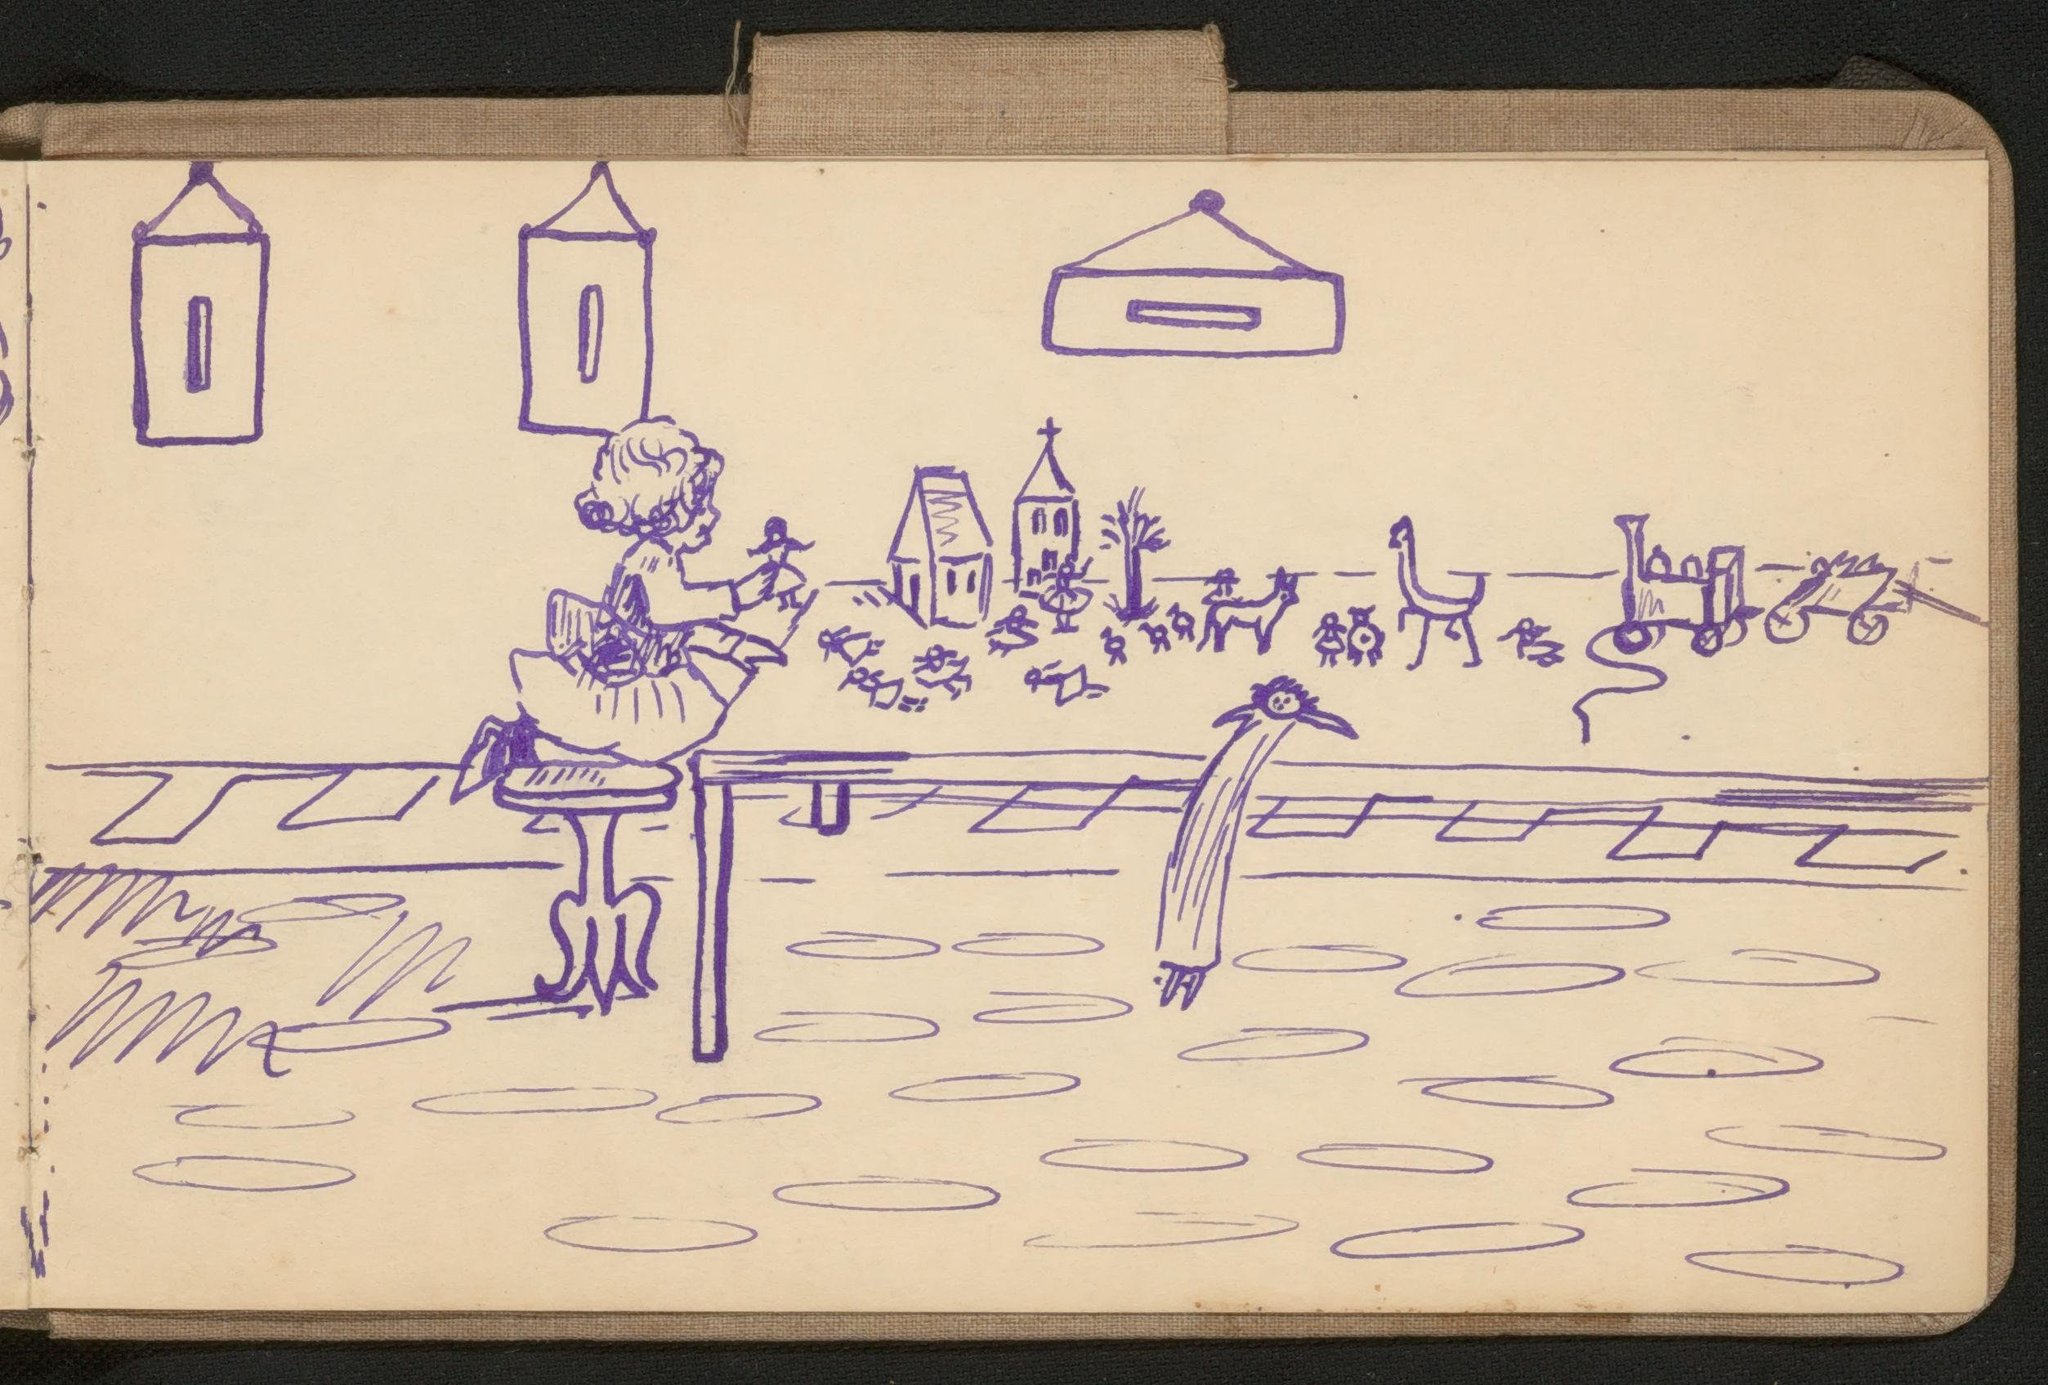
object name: sketchbook leaf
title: Kind met speelgoed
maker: Anonymous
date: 1875-1920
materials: ink, paper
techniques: pen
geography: netherlands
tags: (playing with) toys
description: Kind spelend met speelgoed aan een tafel. Onderdeel van het schetsboek met humoristische tekeningen over het leven van een 'famille nombreuse'. Onderwerpsrubrieken binnen de Atlas Zeden en Gewoonten: Zeden en Gewoonten in Engeren Zin, Des menschen beging, midden en einde, Kinderleven.